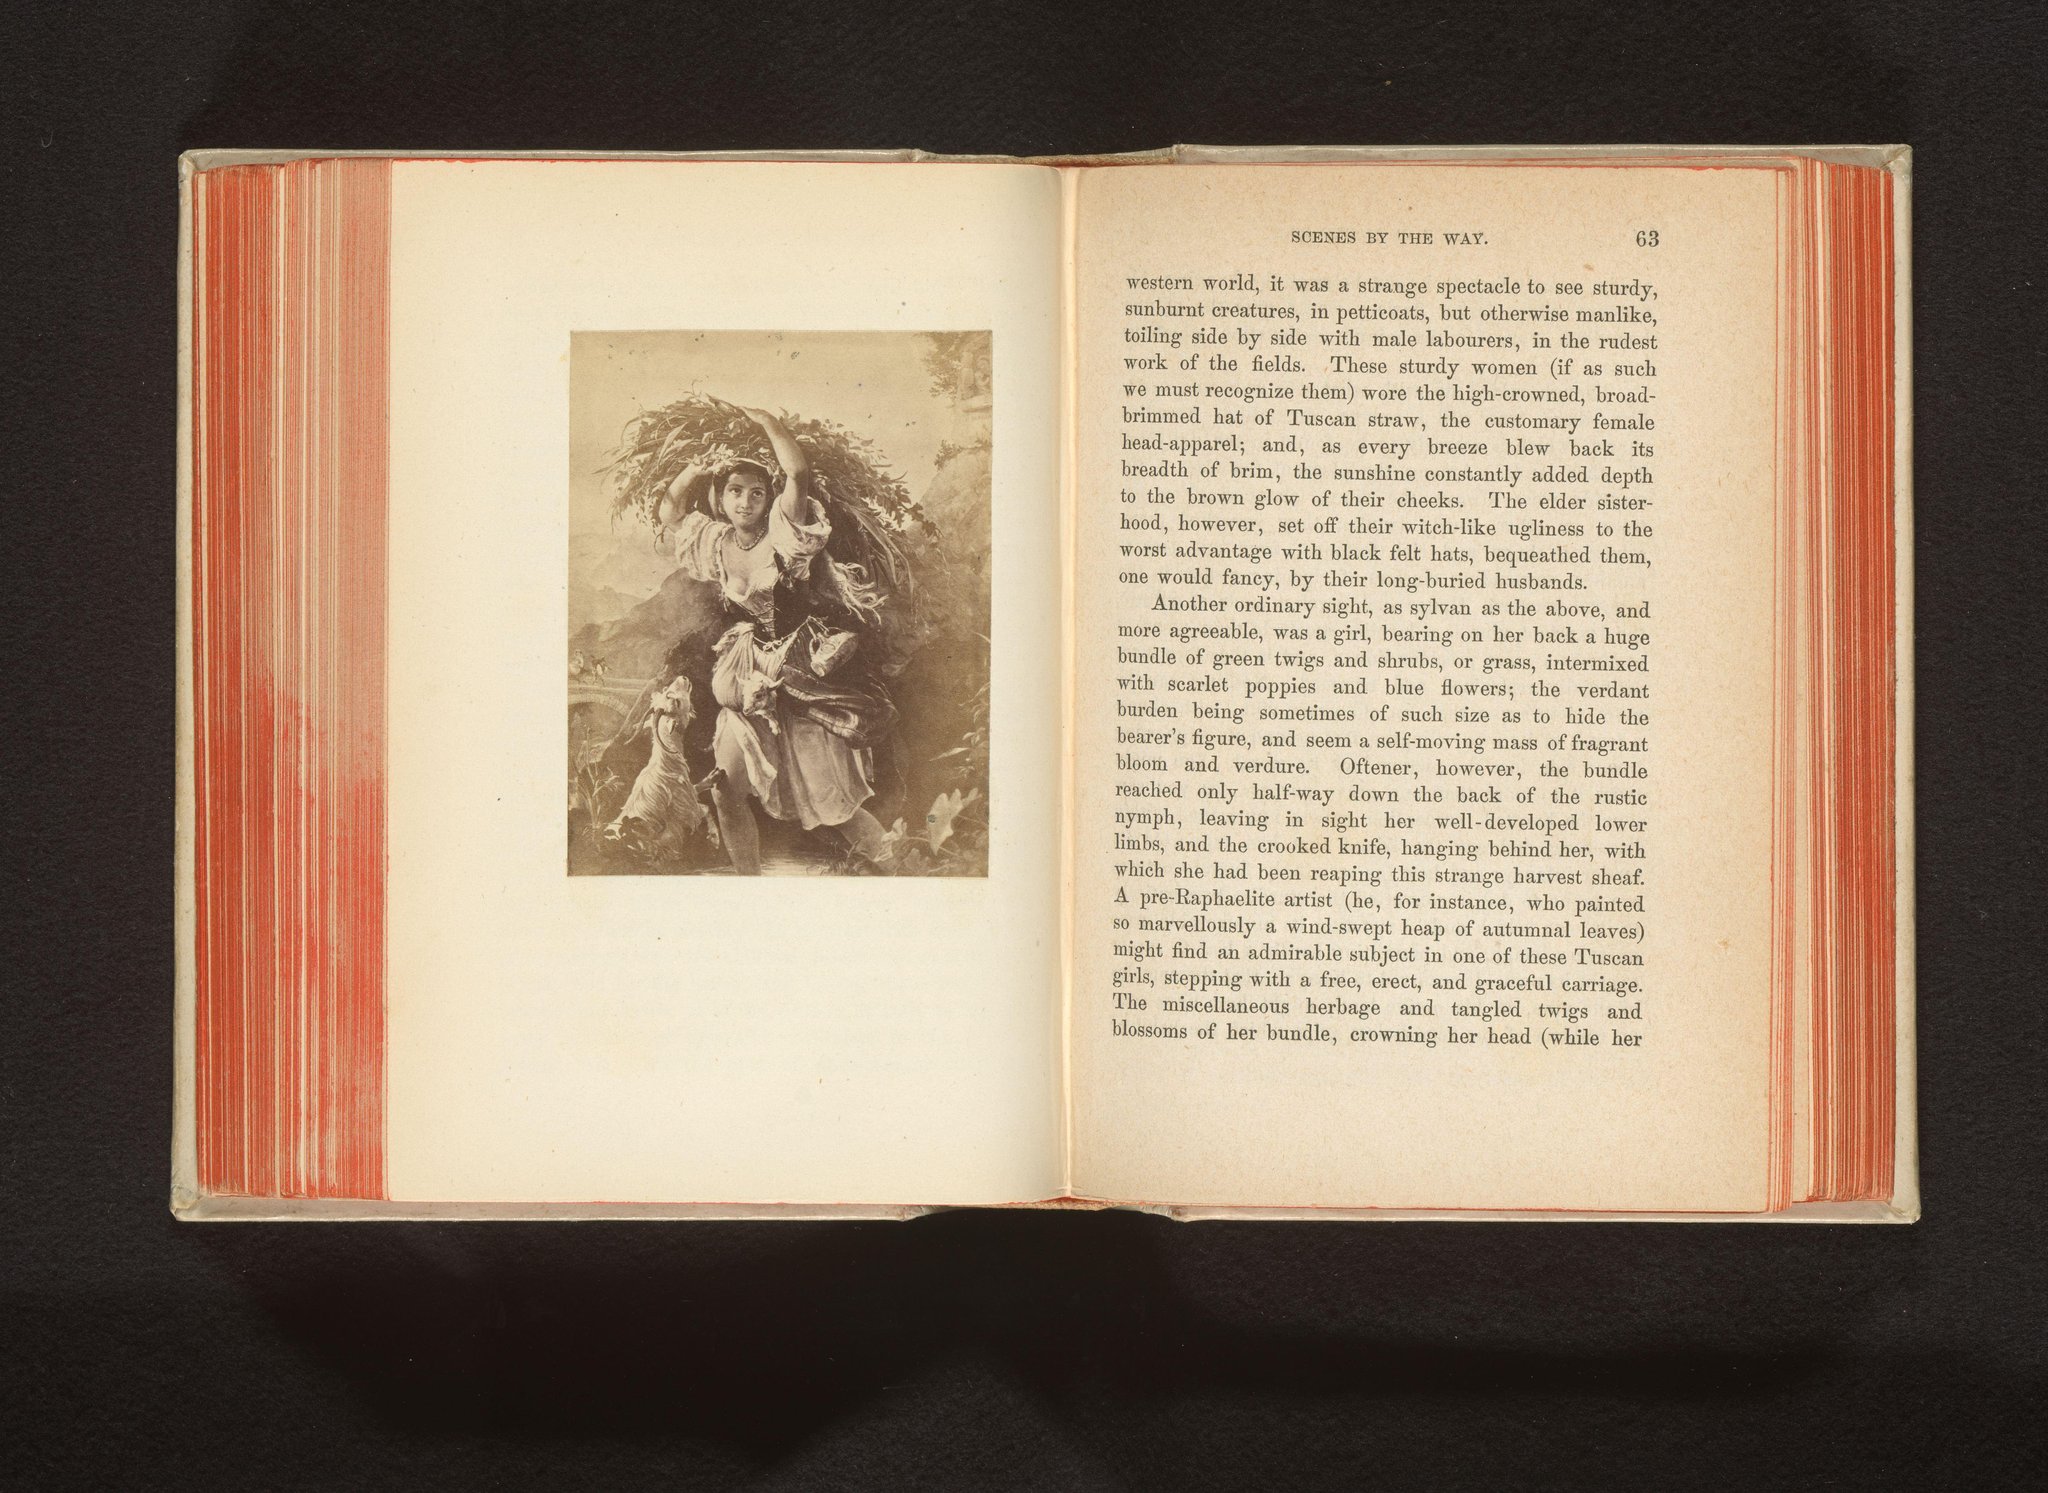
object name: photograph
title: Fotoreproductie van vermoedelijk een tekening van een boerin met oogst boven haar hoofd en twee geiten erbij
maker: Anonymous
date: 1850-1860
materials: photographic support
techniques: albumen print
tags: farmers - aa - female farmer, farmer's wife